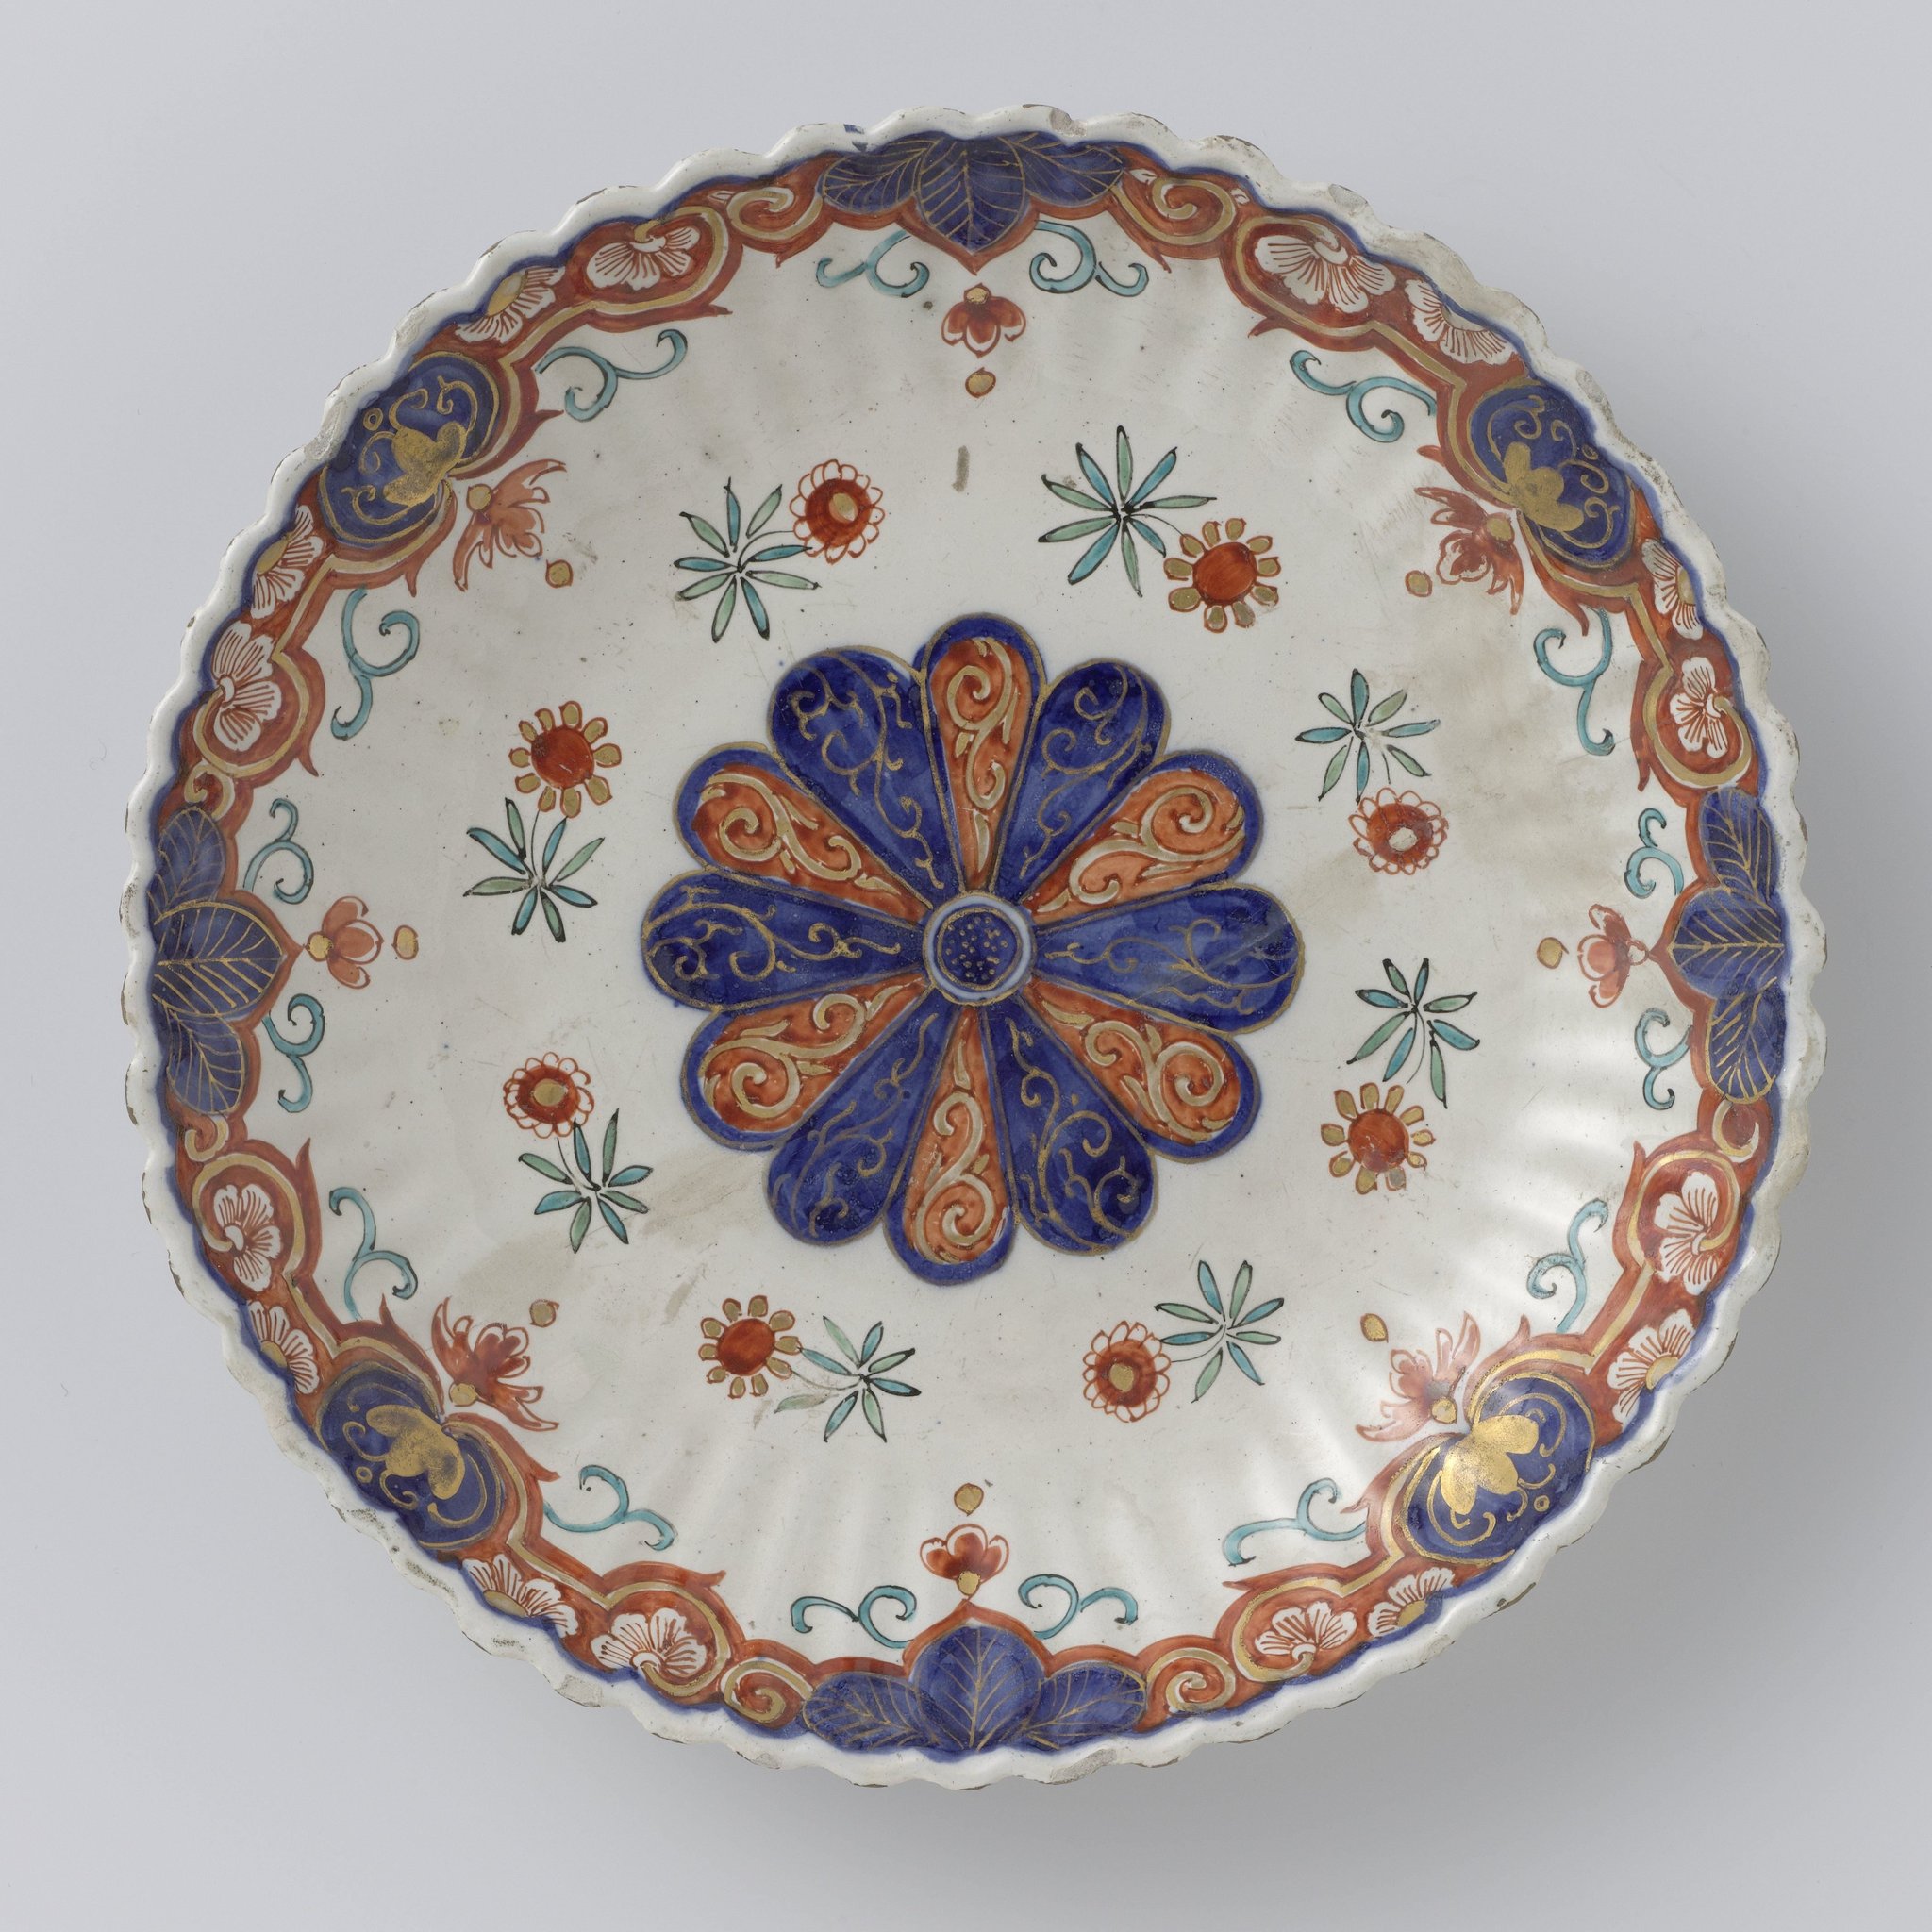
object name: dish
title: Schaal van veelkleurig beschilderde faïence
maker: adriaan van rijsselbergh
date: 1700-1725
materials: earthenware, glaze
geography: delft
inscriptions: collector's mark: ‘collection loudon’, mark: ‘AR (ineen)’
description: Schaal van faïence. Veelkleurig beschilderd met een rozet en strooibloemen. Gemerkt met het monogram A R.